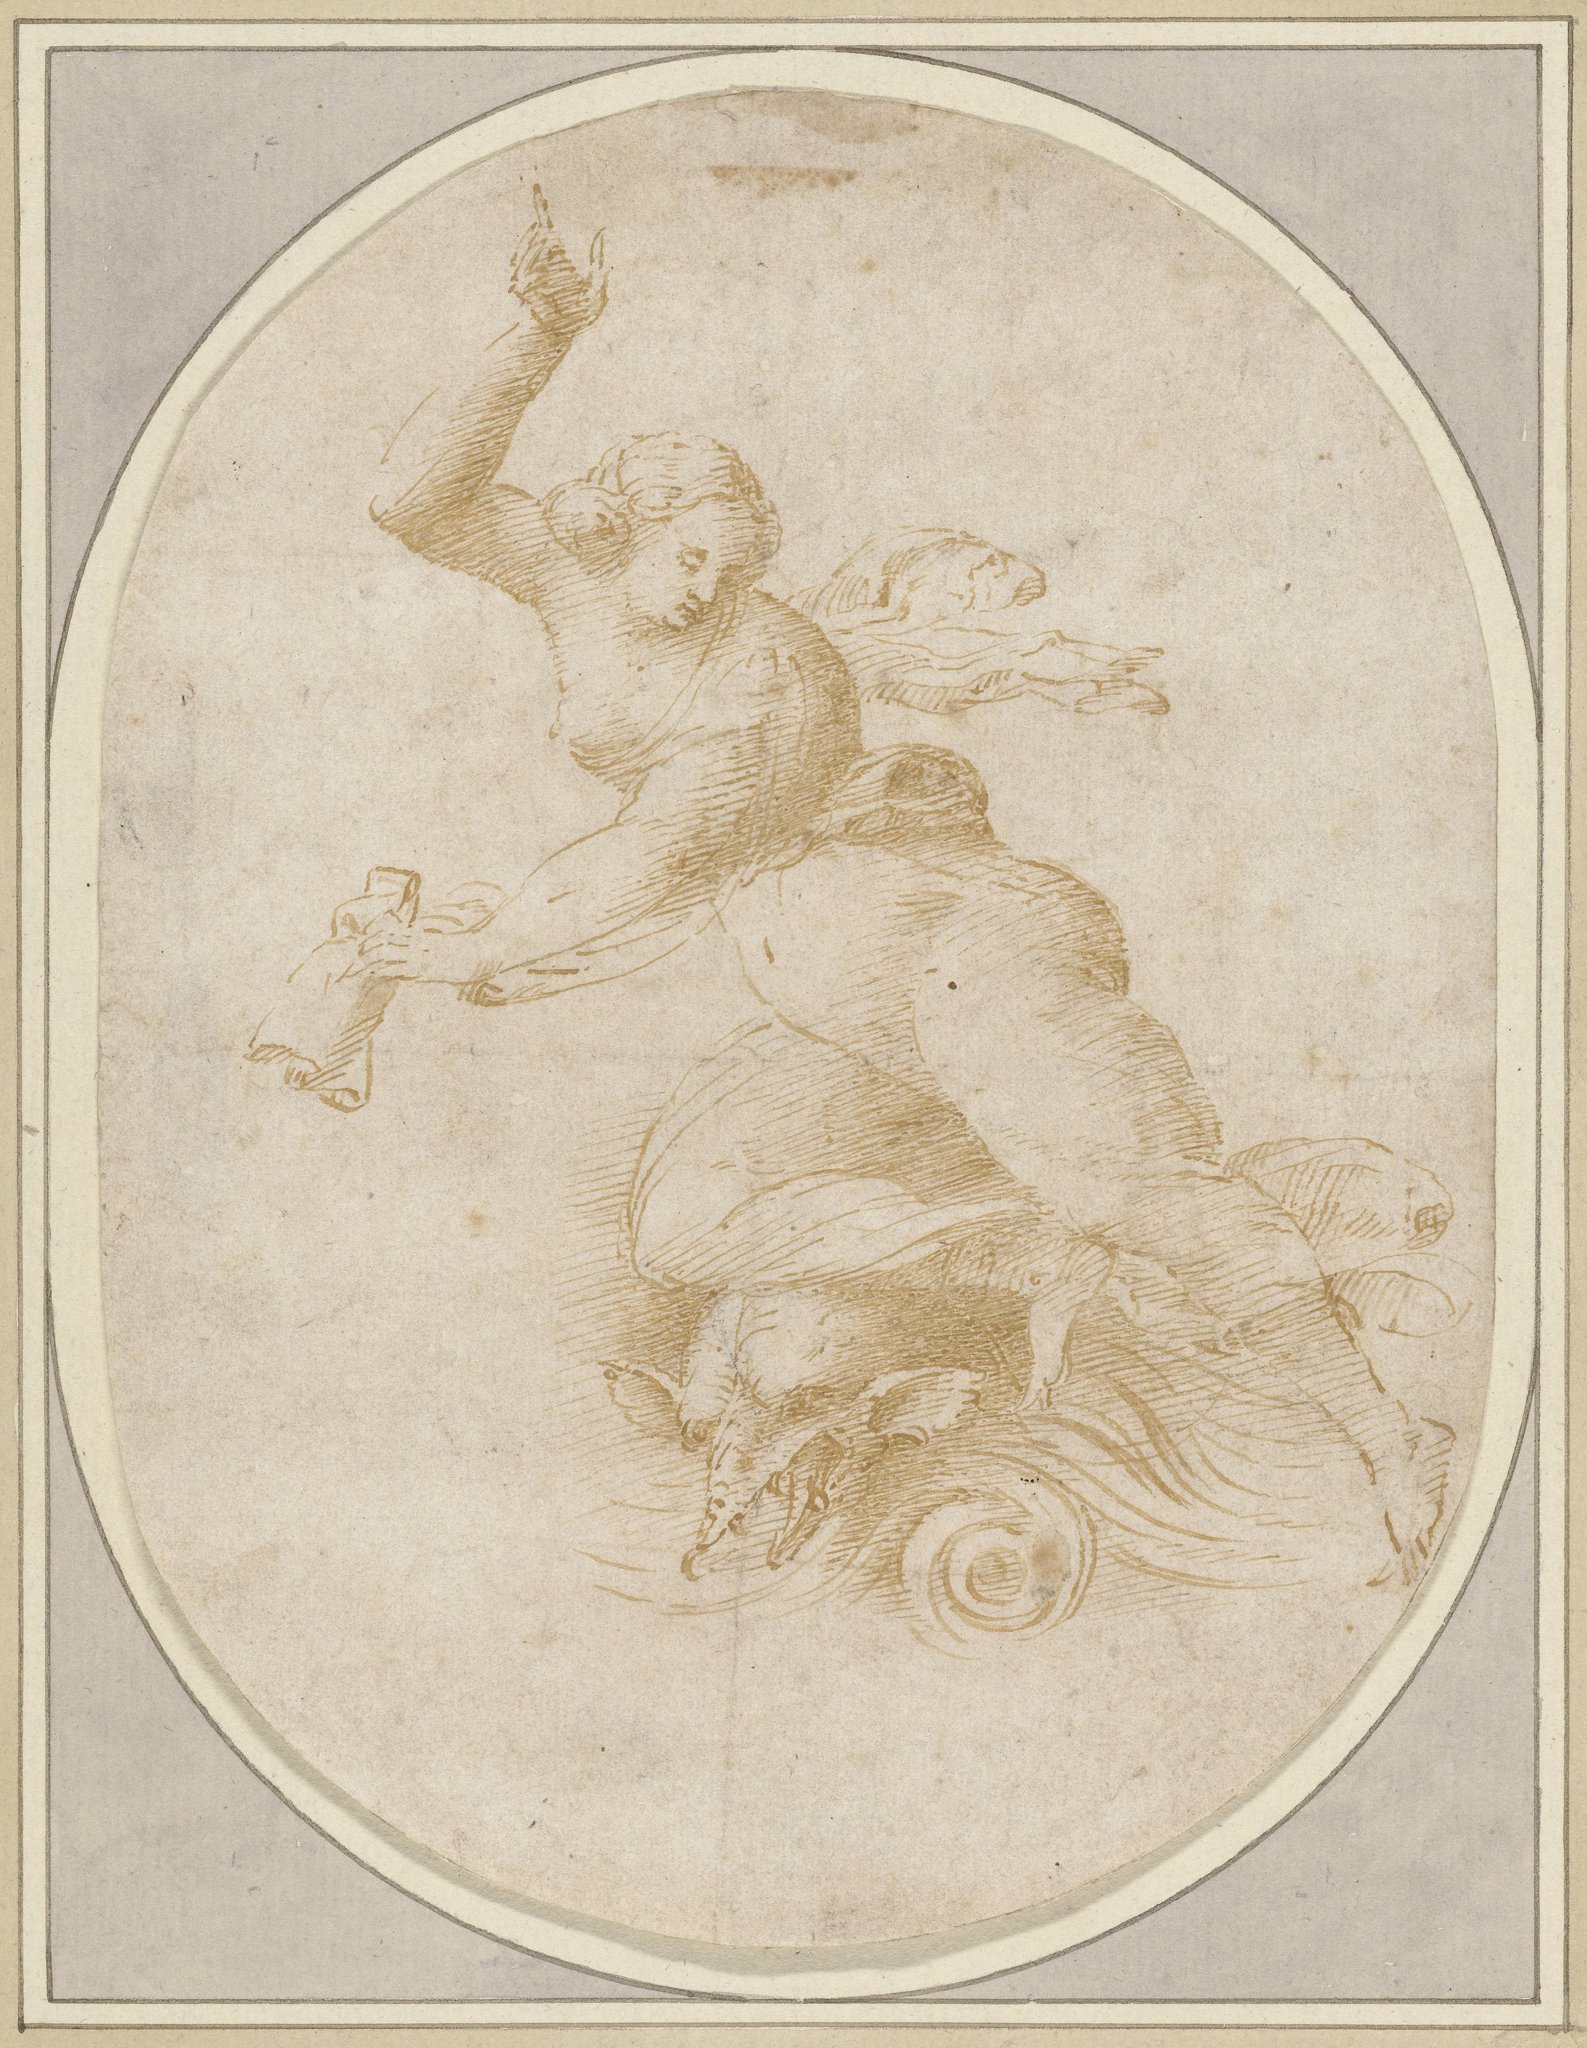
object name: drawing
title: Galatea op een dolfijn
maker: jacopo de barbari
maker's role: draughtsman, print maker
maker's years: 1440-1516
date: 1490-1513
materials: ink, paper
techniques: pen